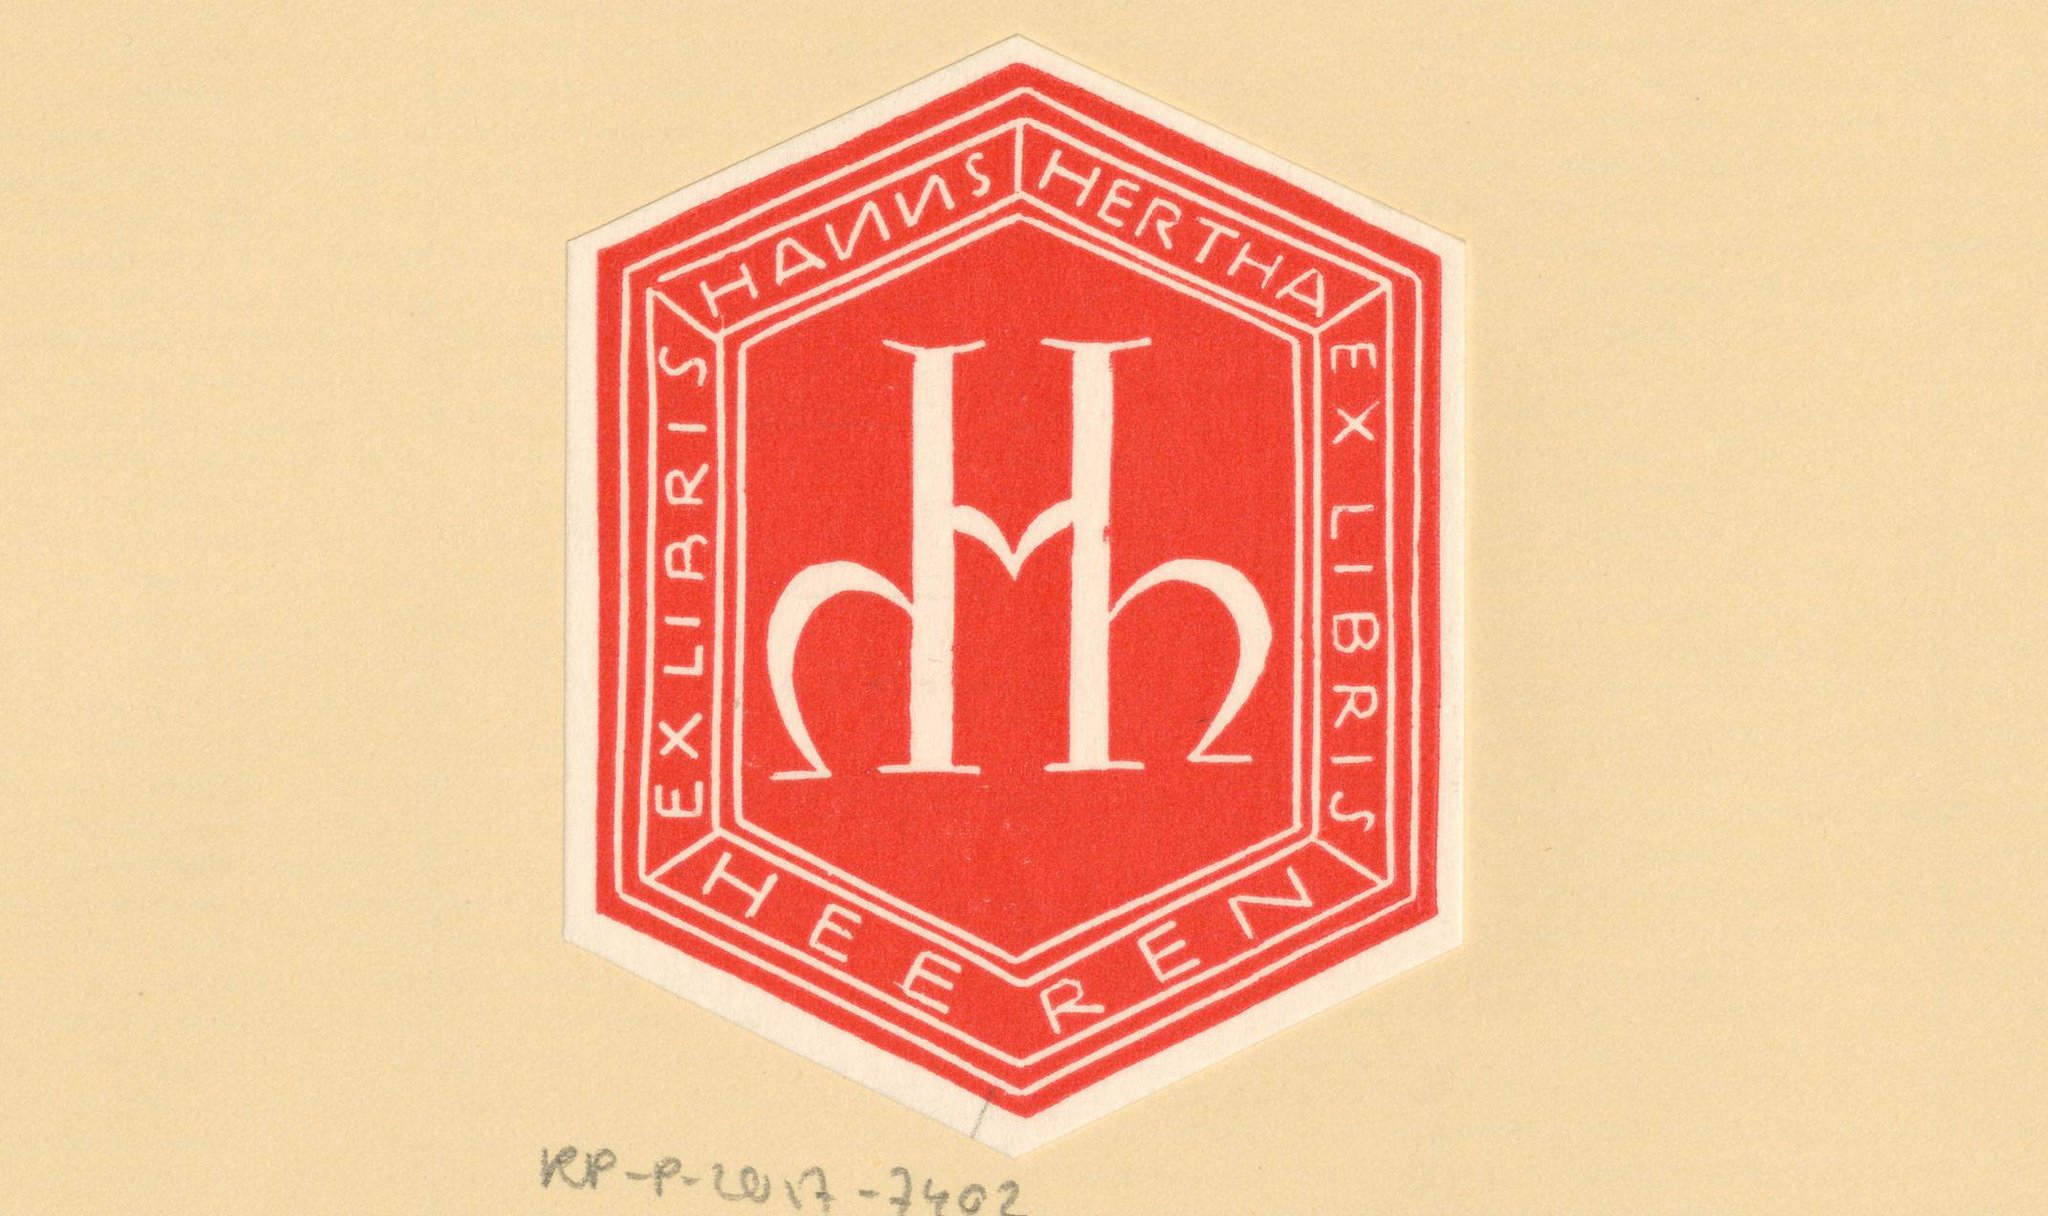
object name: bookplate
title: Ex libris van Hanns en Herta Heeren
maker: karl michel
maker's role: painter, print maker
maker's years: 1885-1966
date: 1922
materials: paper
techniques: woodcut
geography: austria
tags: hanns heeren, hertha heeren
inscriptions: workshop stamp: ‘Karl Michel/ Holzschnitt’